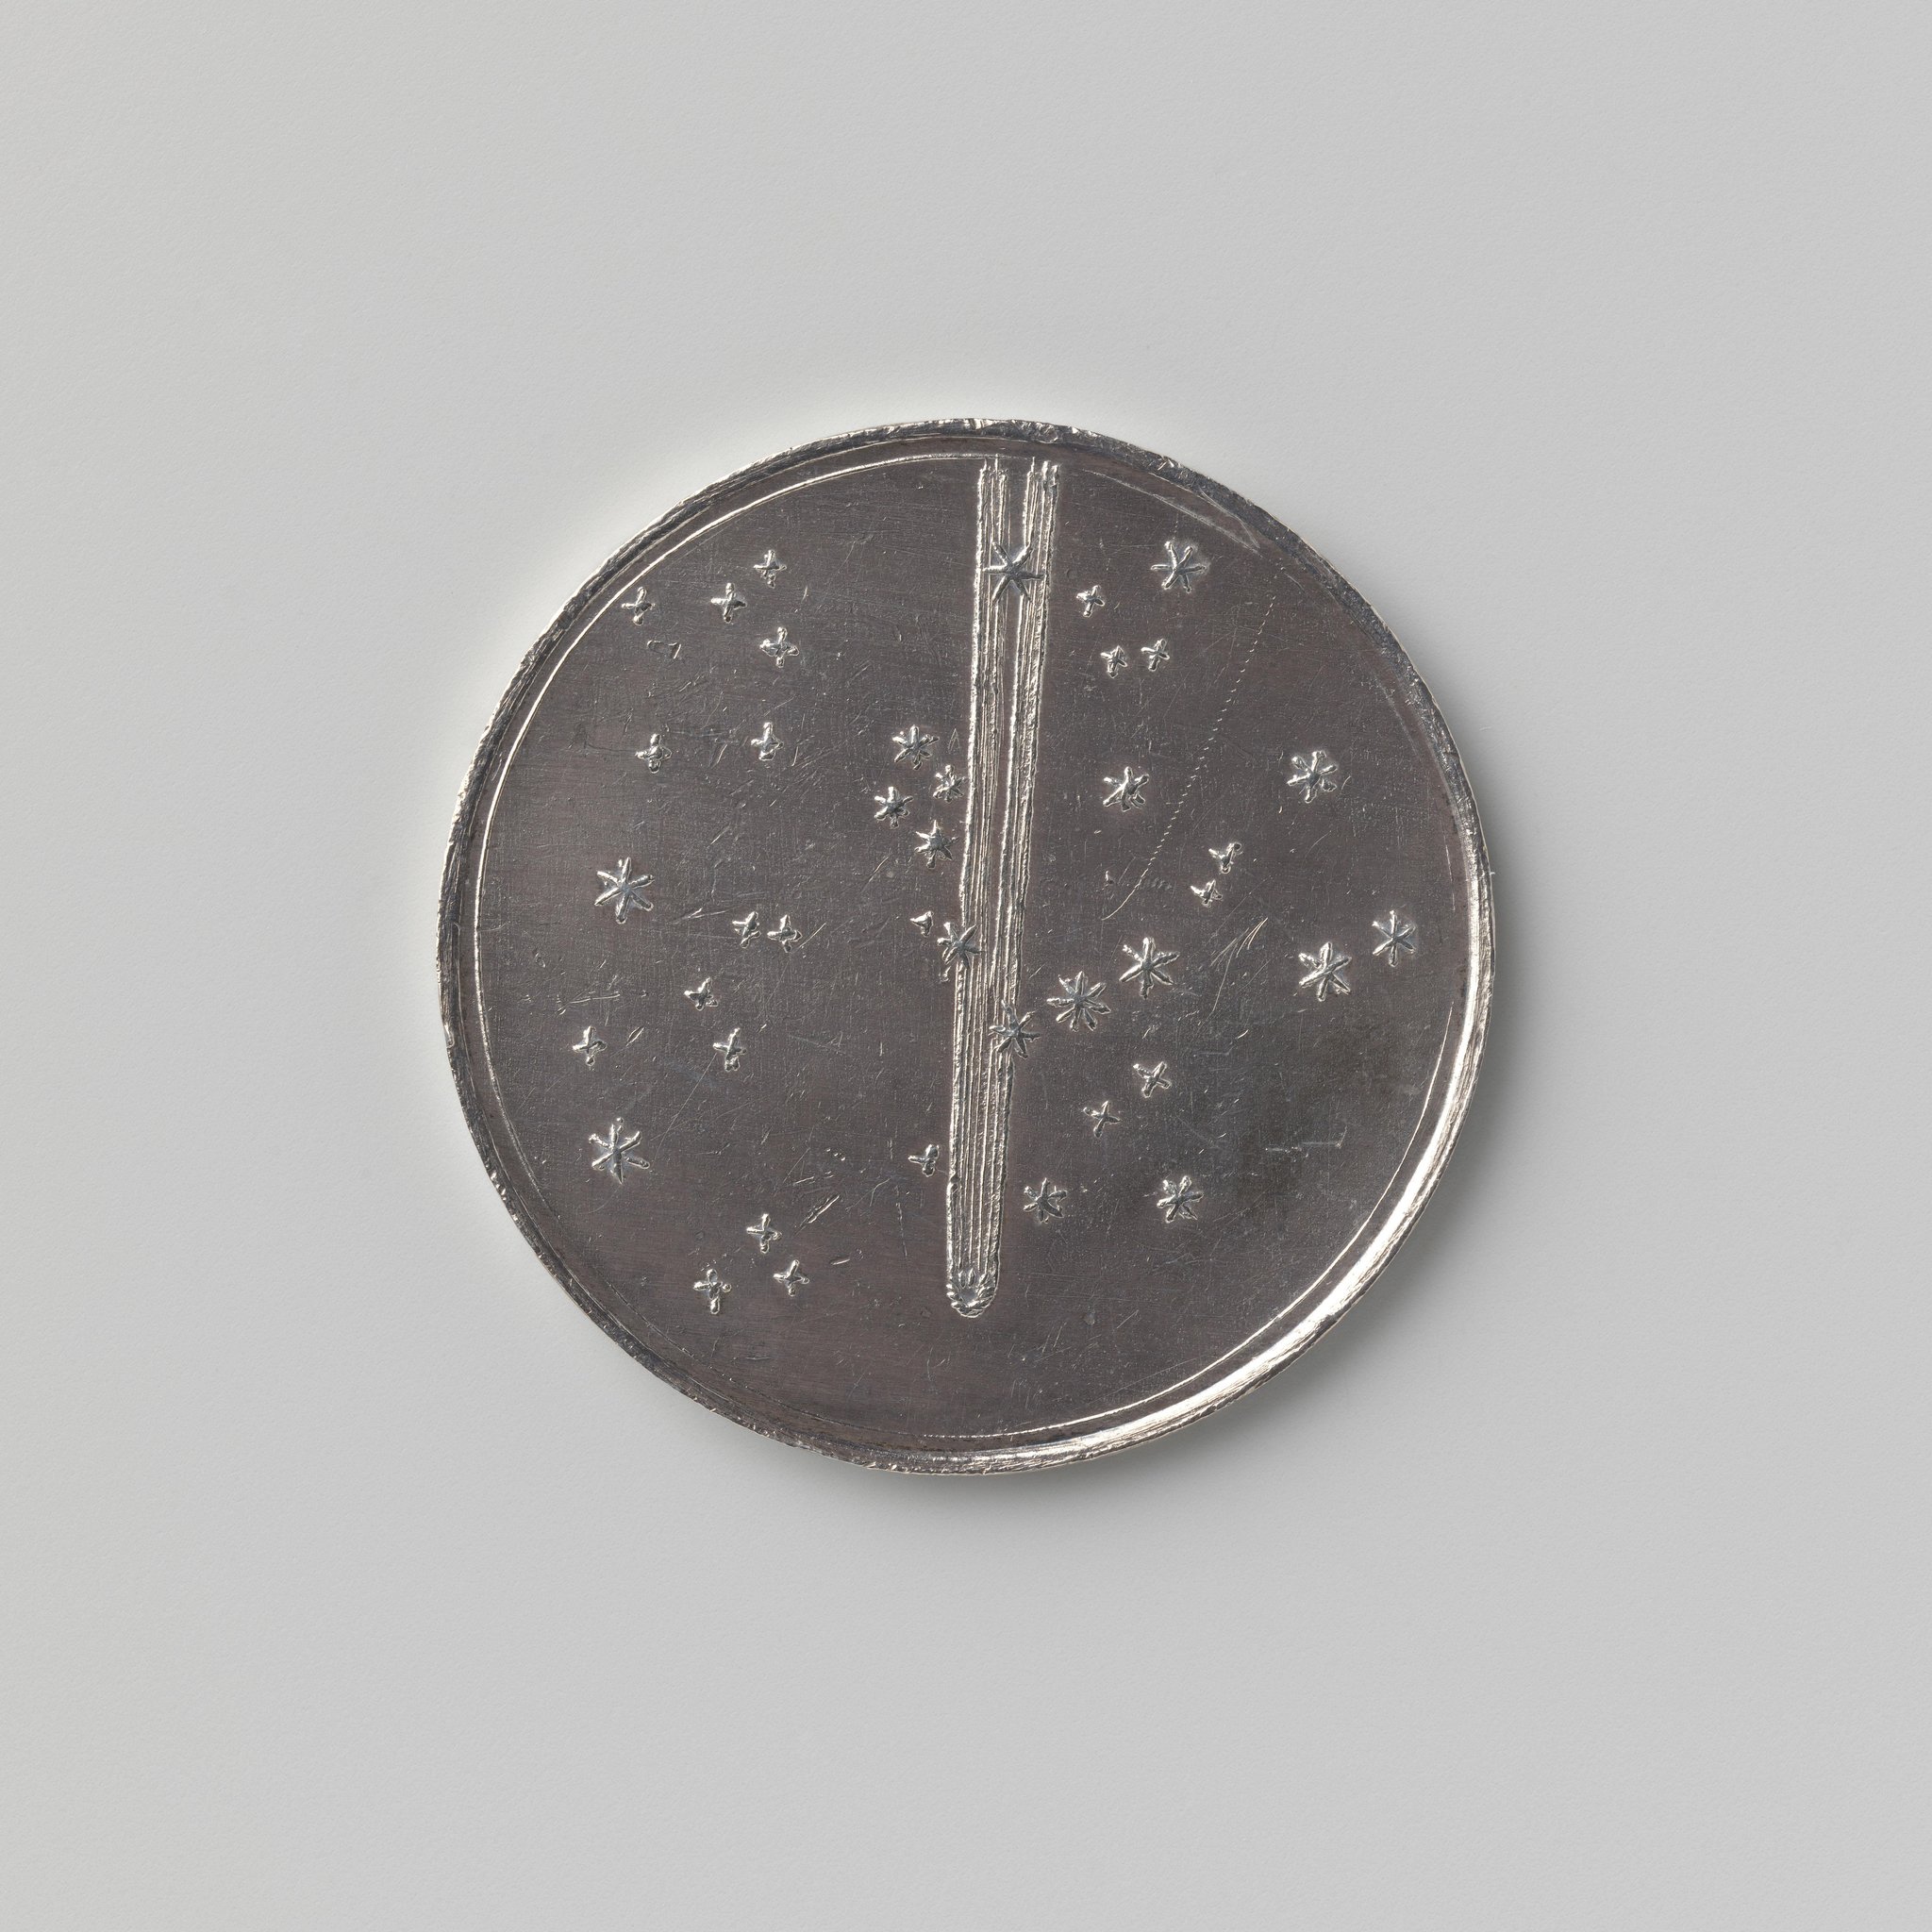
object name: history medal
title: Verschijning van een komeet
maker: Anonymous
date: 1681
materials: silver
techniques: striking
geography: germany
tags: netherlands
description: Zilveren penning. Voorzijde: de komeet temidden van een aantal sterren. Keerzijde: opschrift